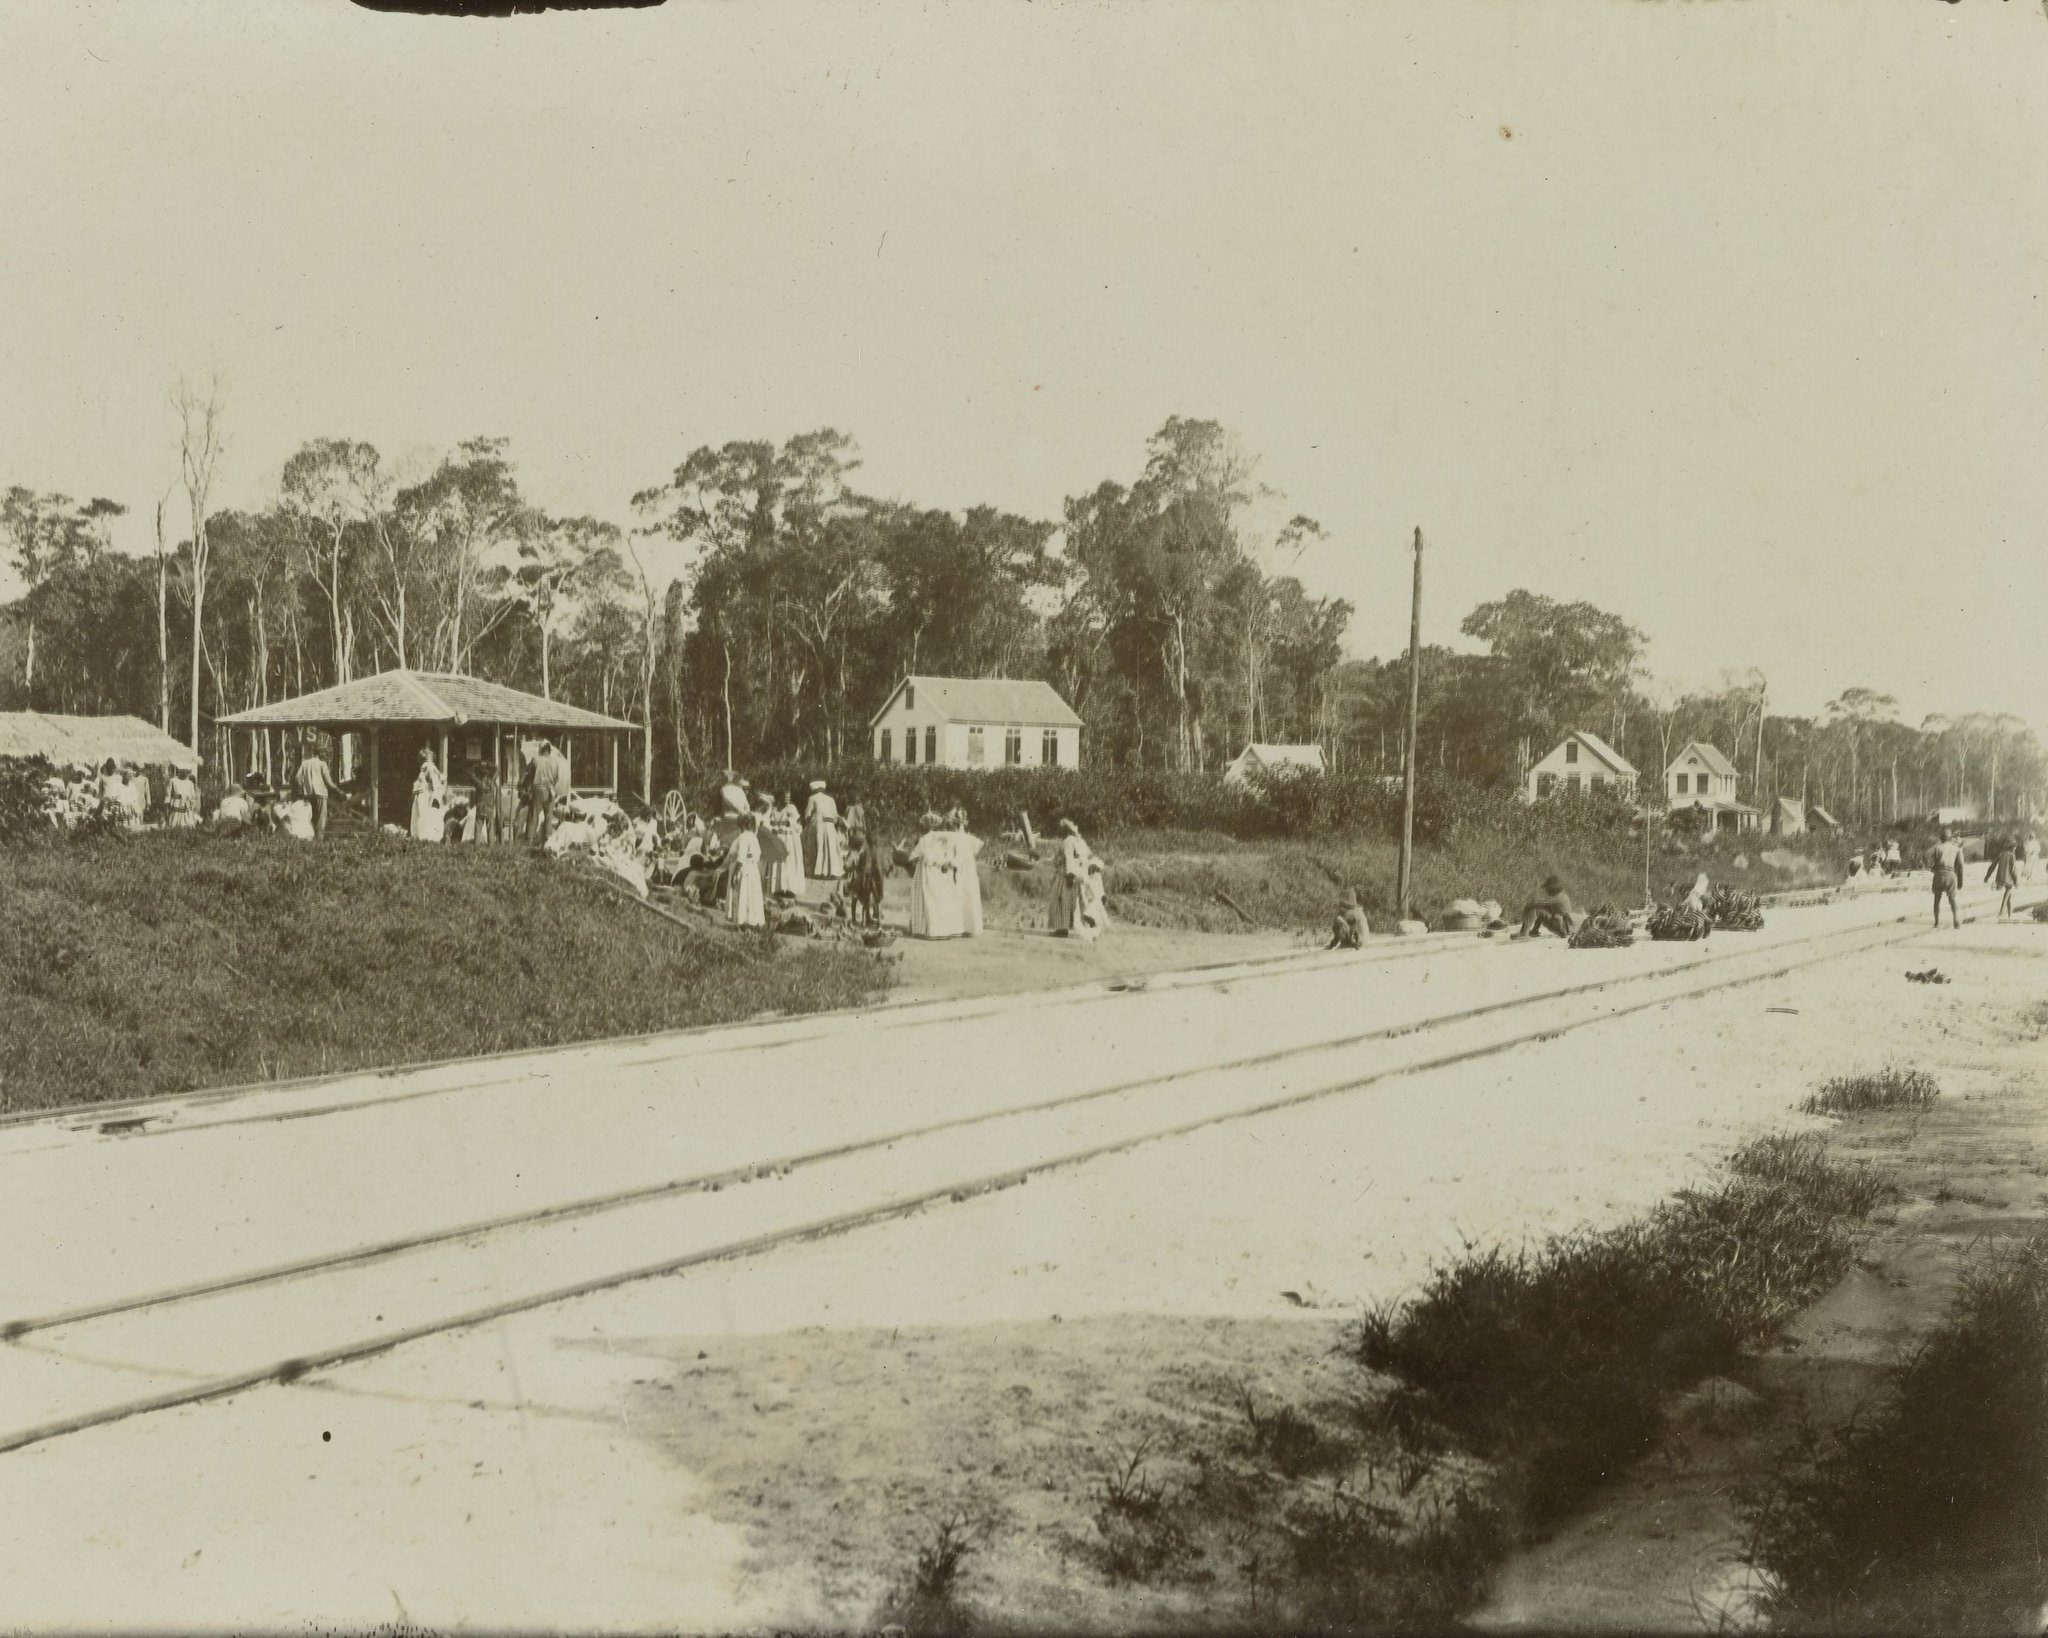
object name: photograph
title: Feest ter gelegenheid van de spoorlijn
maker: Anonymous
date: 1905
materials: photographic support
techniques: photography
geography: paramaribo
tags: railway, train, rejoicing on special occasions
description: Feestelijkheden bij de opening van het eerste baanvak van de Lawaspoorweg, van Paramaribo tot Republiek, in 1905.